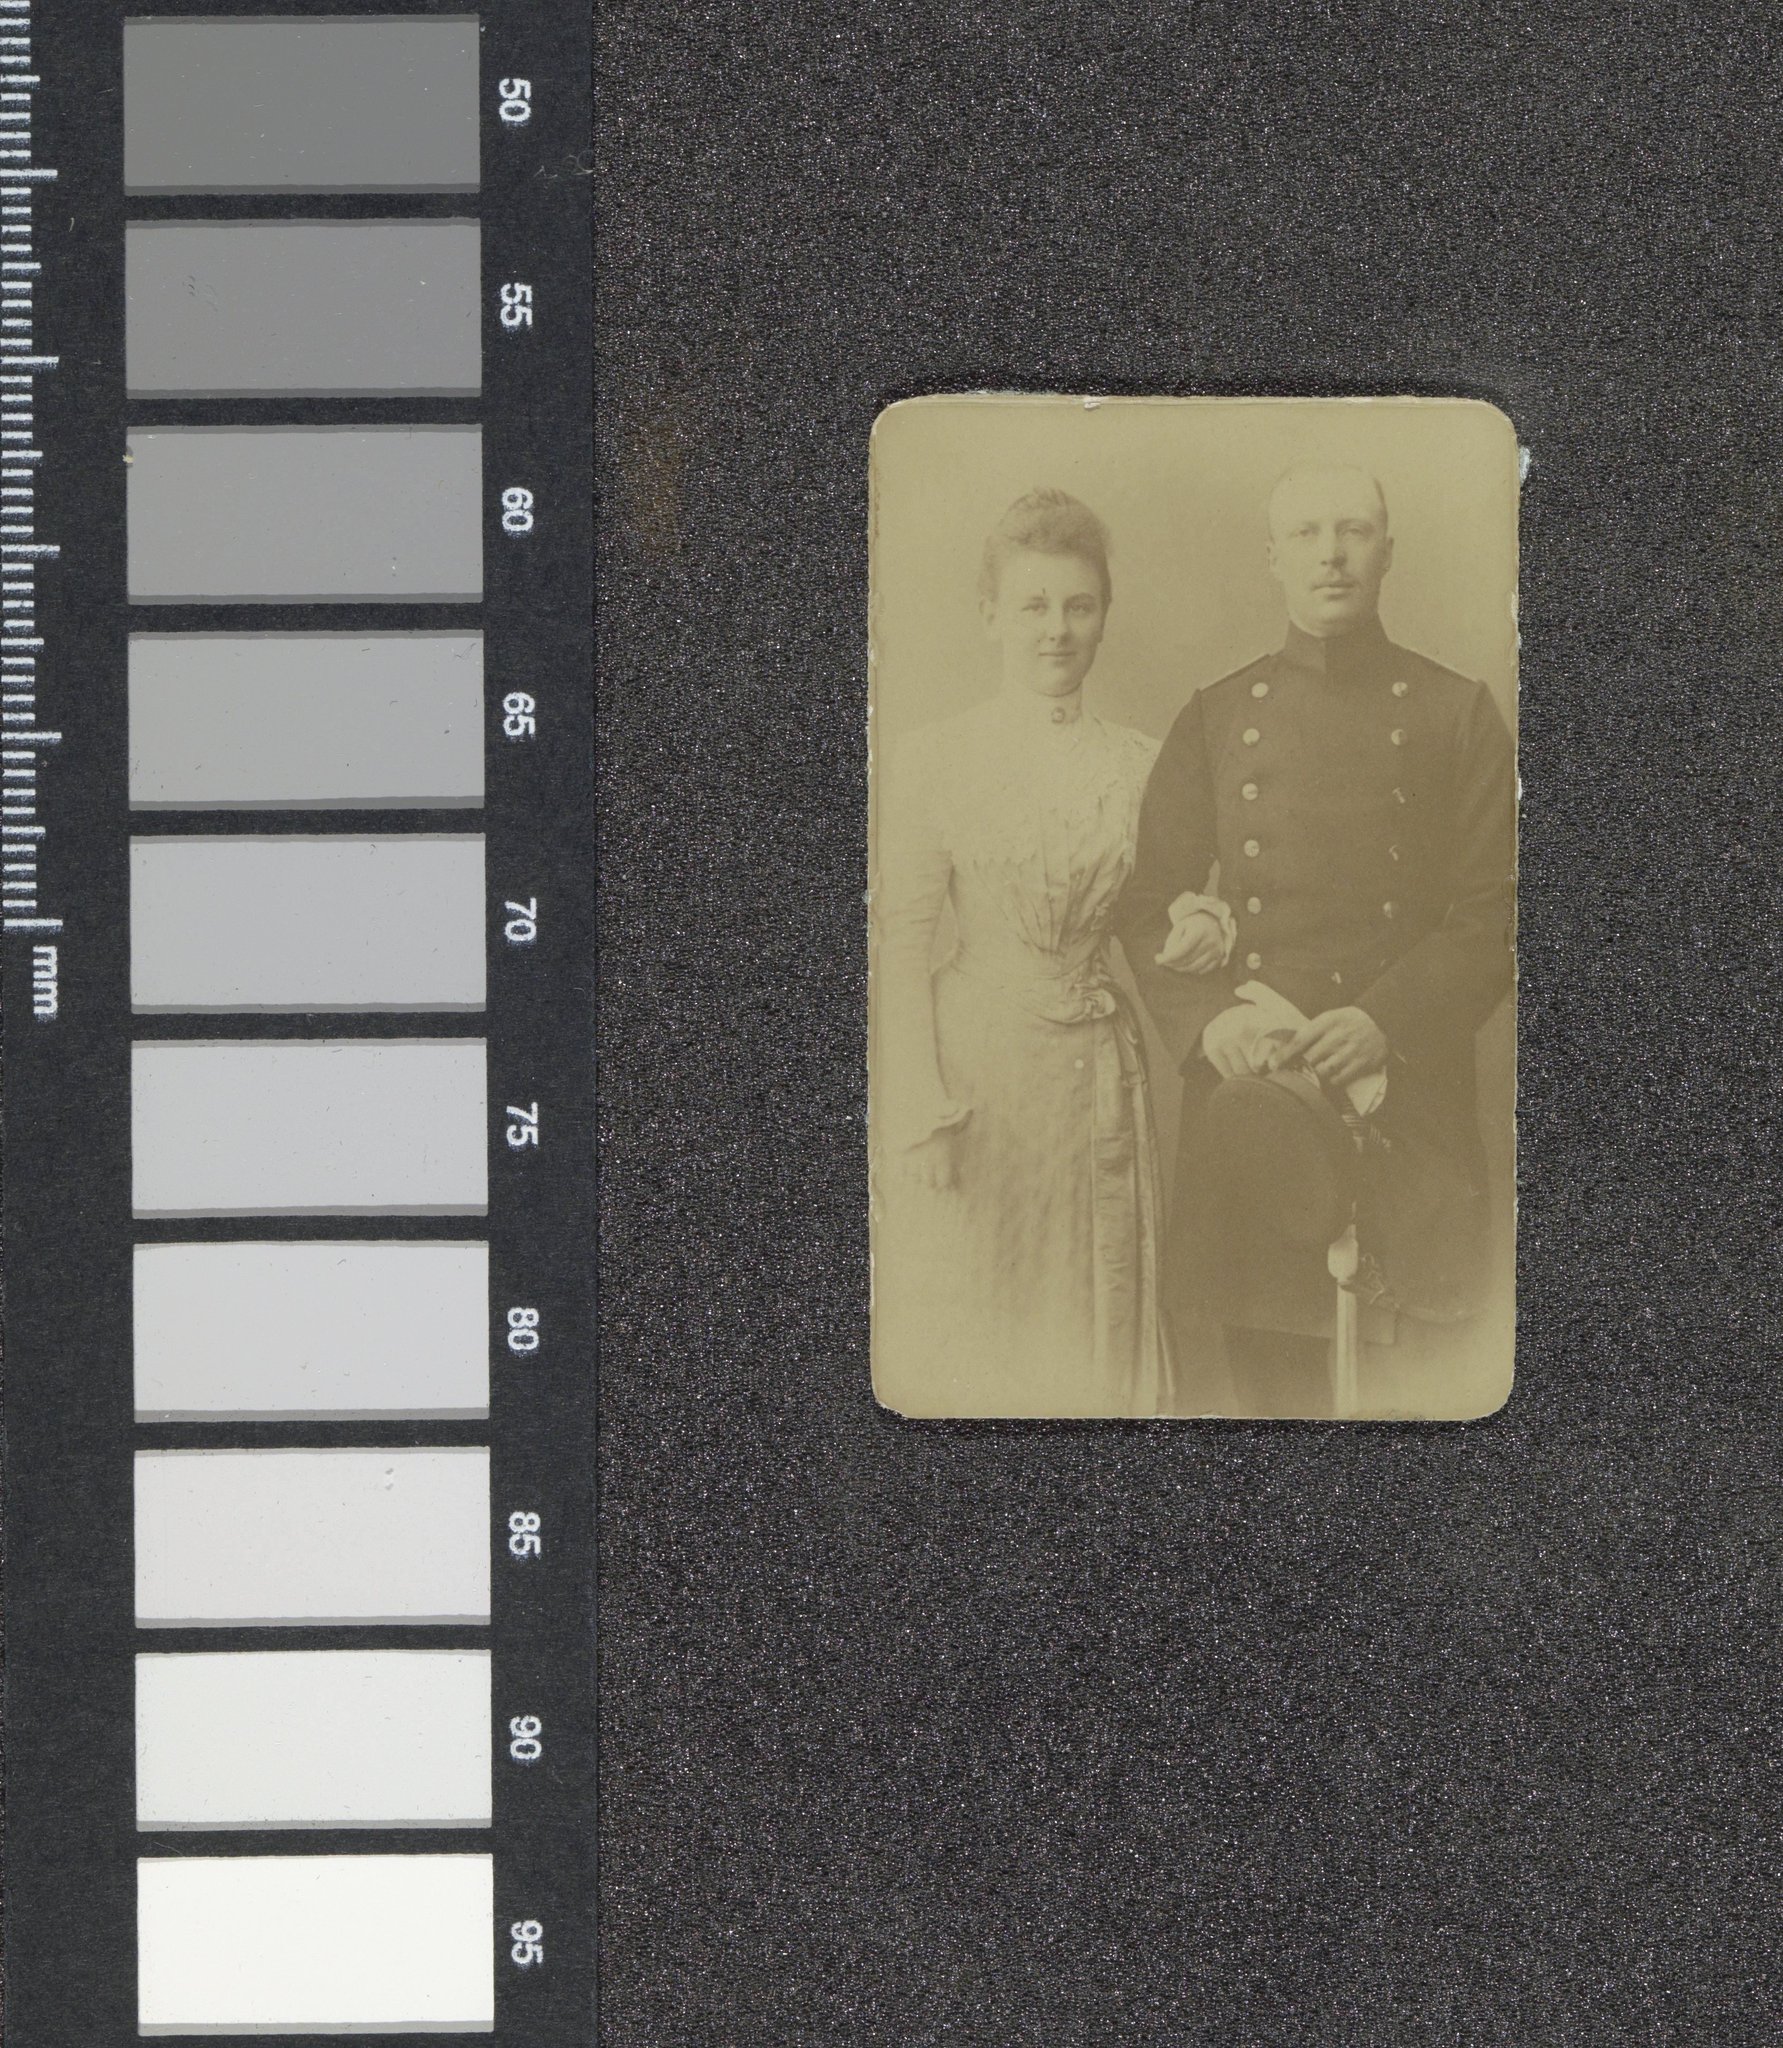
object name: photograph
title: Portret van Koningin Wilhelmina met Prins Hendrik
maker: Anonymous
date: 1901-1905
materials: paper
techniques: albumen print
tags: the hague, print maker, wilhelmina of the netherlands, hendrik (prins der nederlanden (1876-1934))